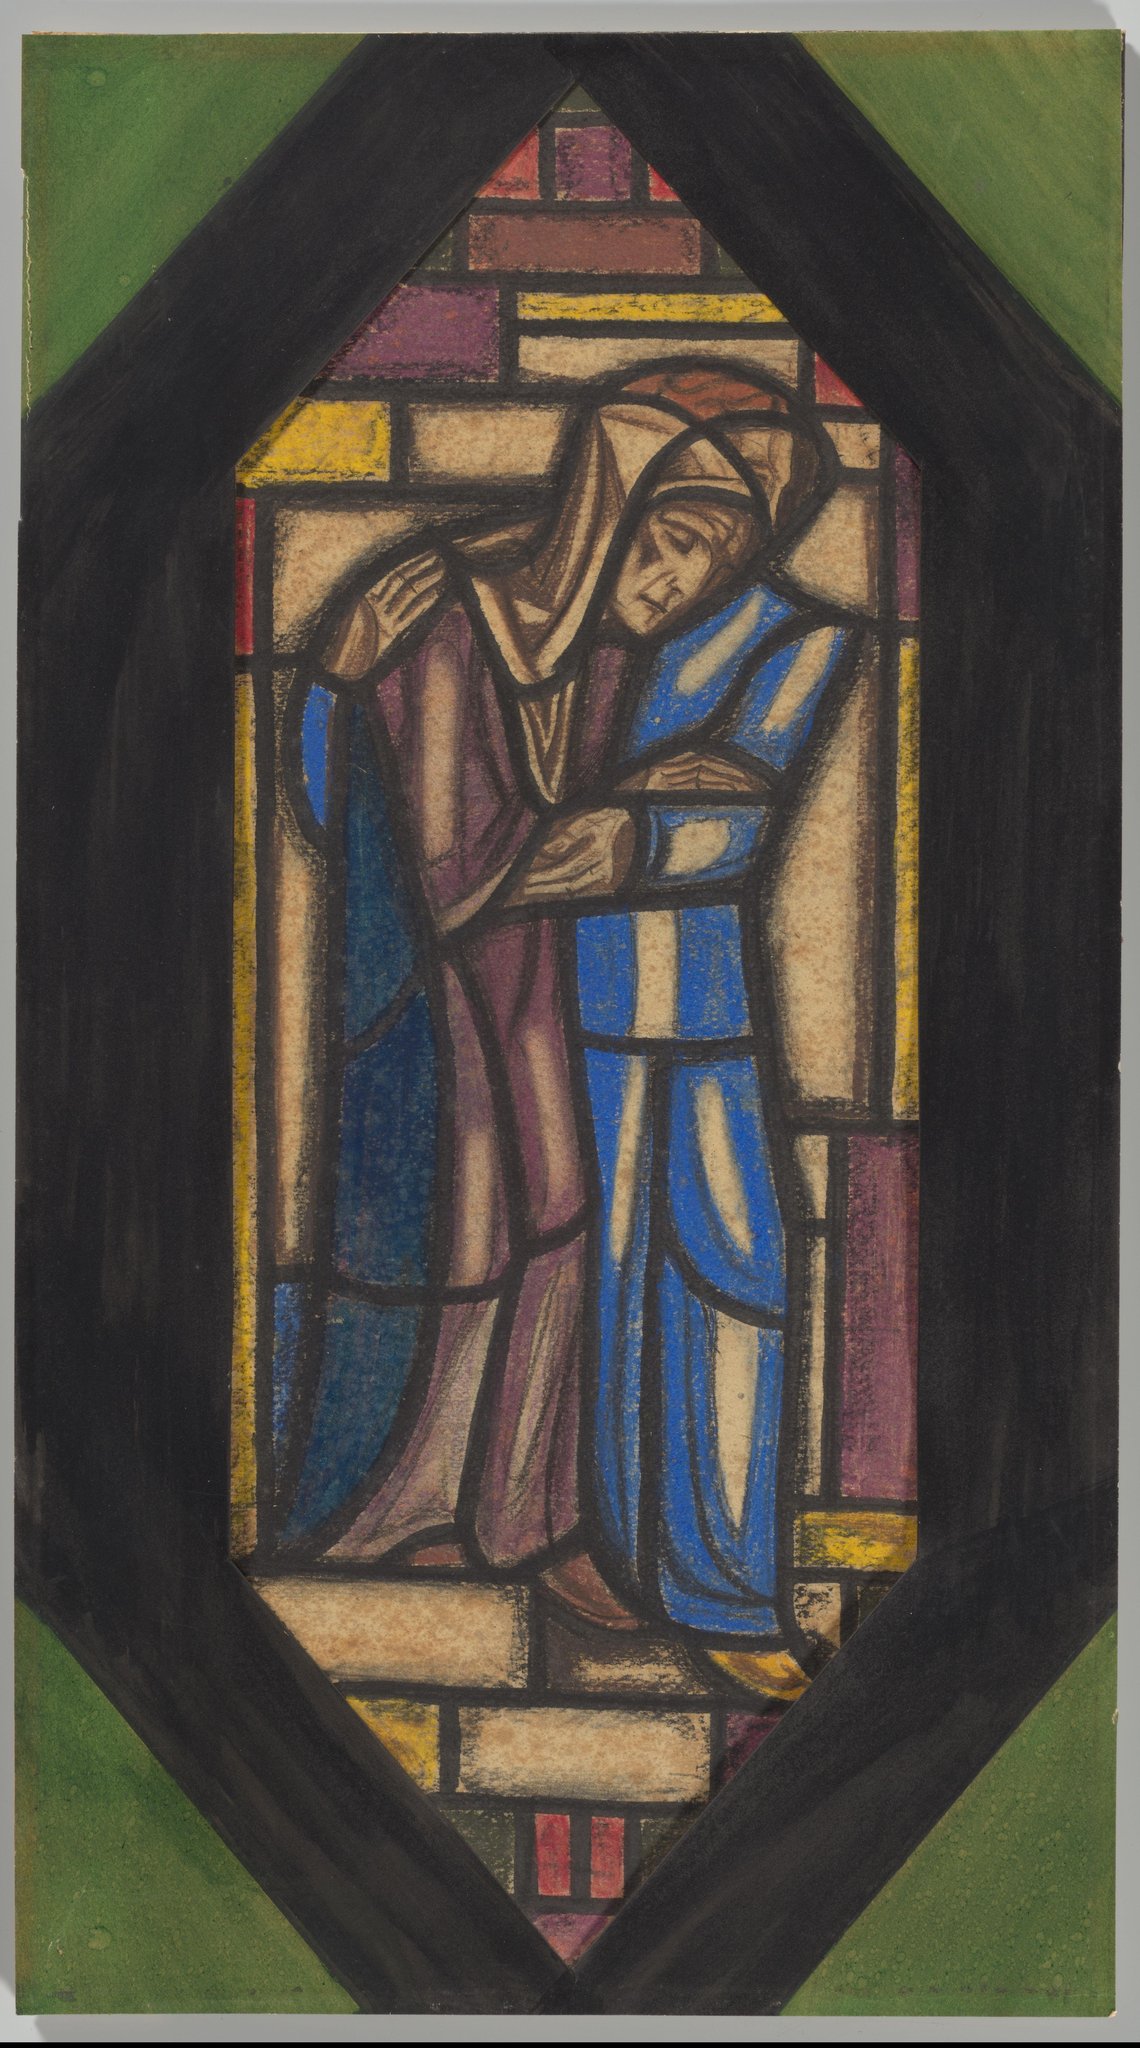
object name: drawing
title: Ontwerp voor raam in het postkantoor te Haarlem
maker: richard nicolaüs roland holst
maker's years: 1868-1938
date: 1922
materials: cardboard, chalk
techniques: brush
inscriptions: monogram: ‘RNRH’